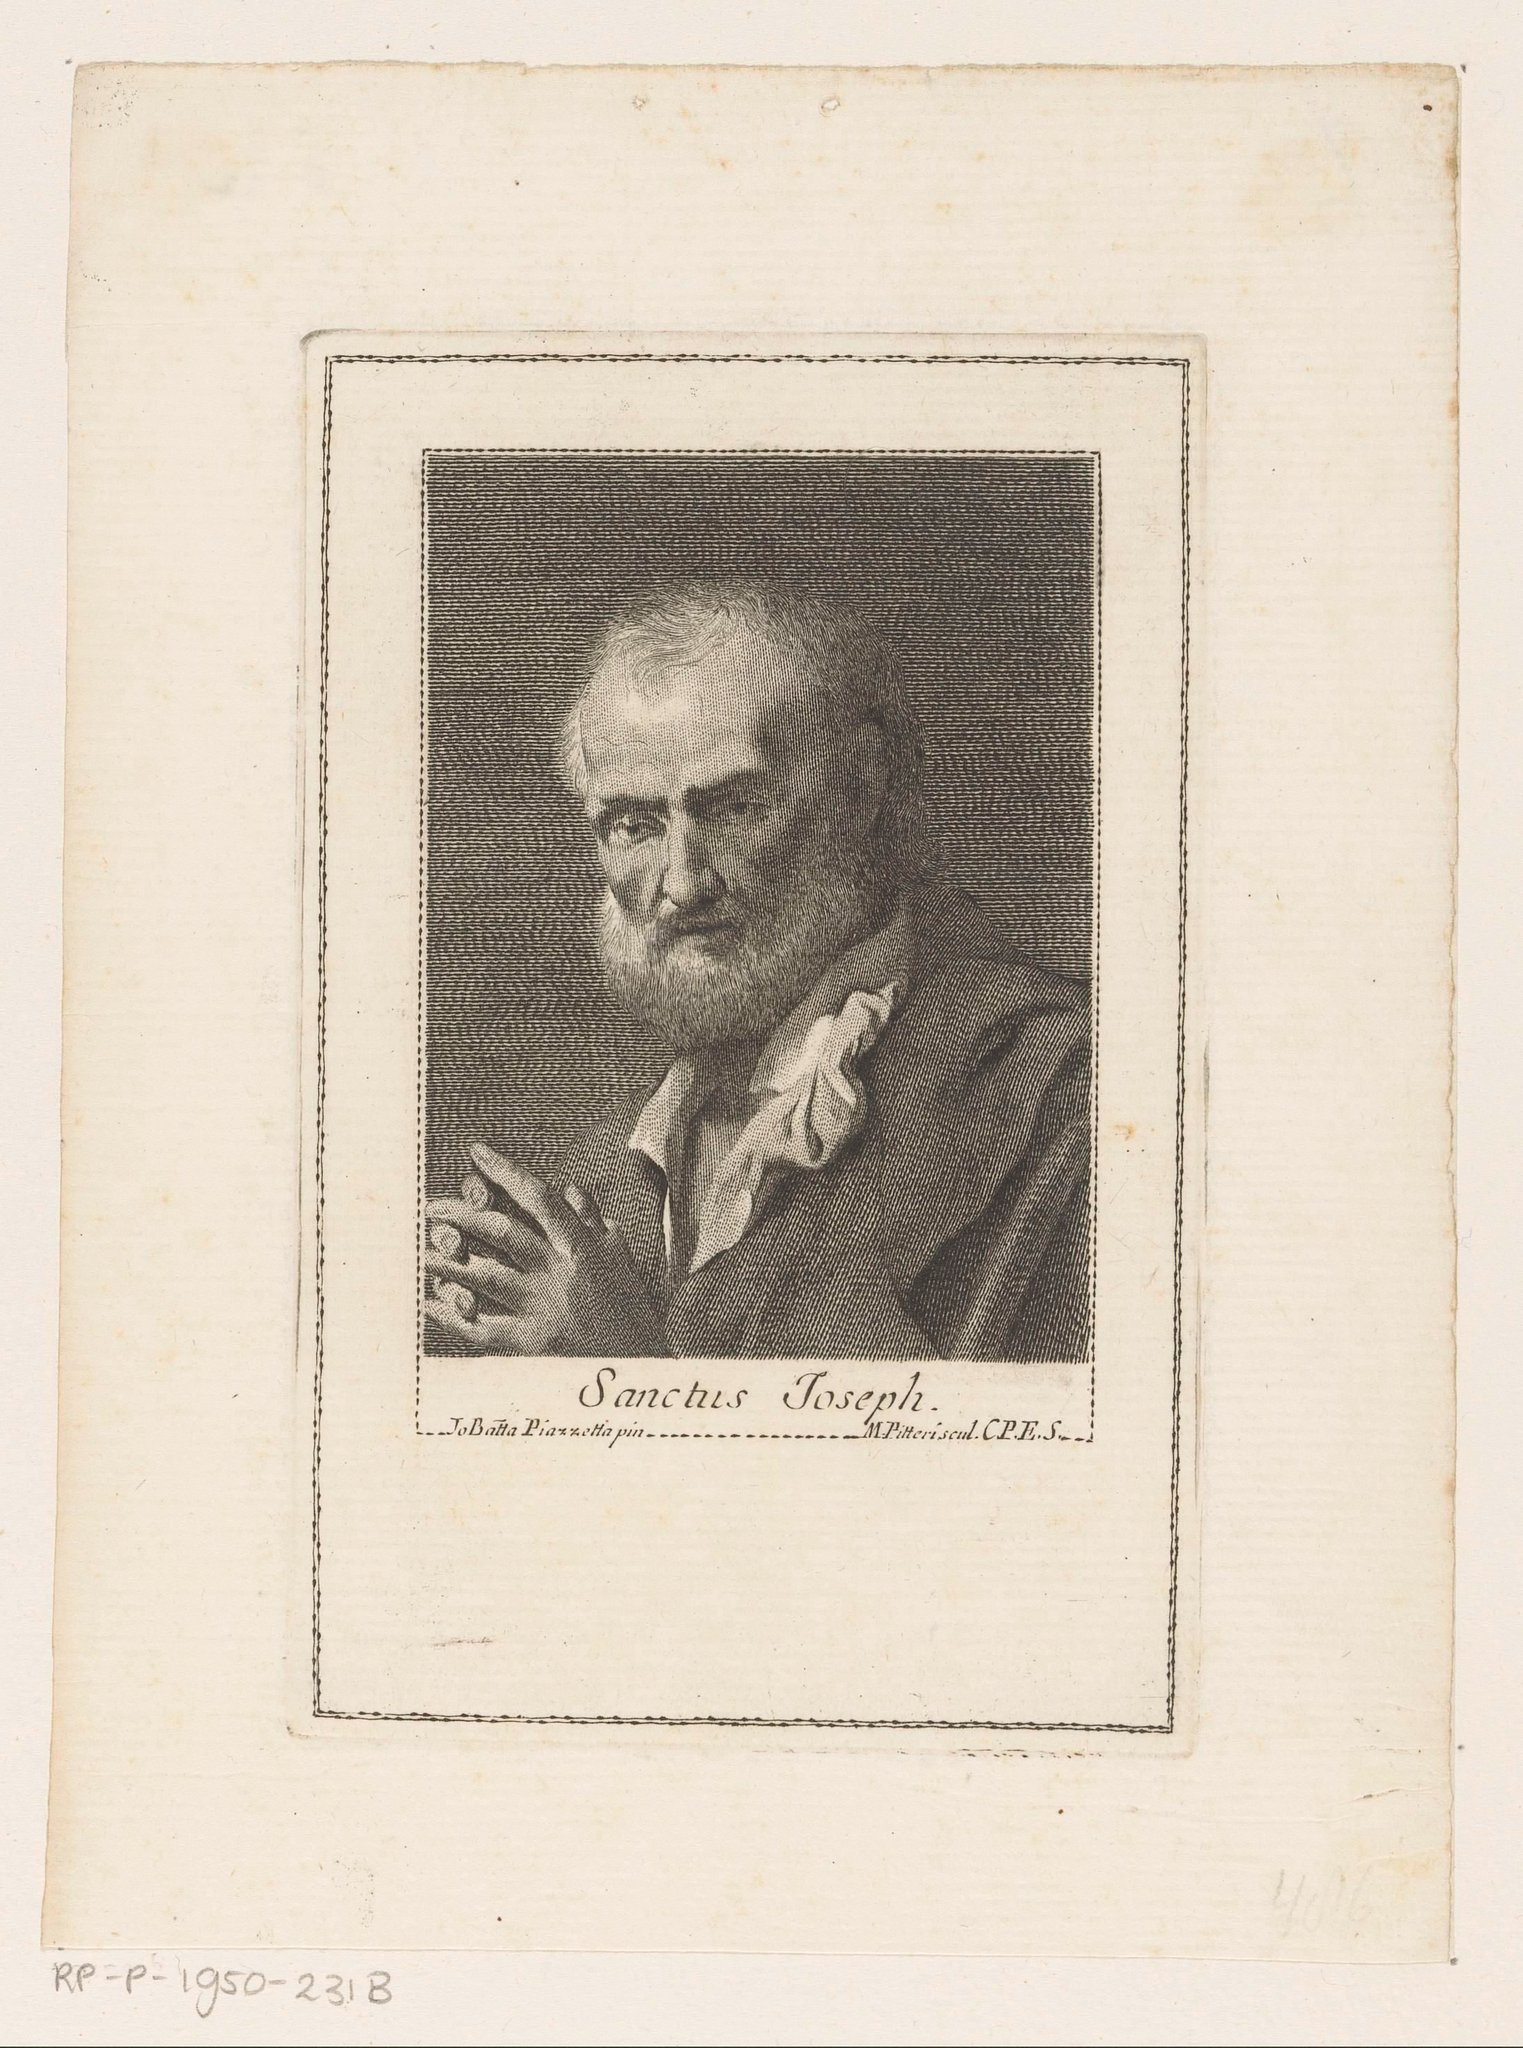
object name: print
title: Sanctus Joseph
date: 1712-1786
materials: paper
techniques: engraving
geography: venice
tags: the foster-father of christ, joseph of nazareth, husband of mary; possible attributes: flowering rod or wand, lily, carpenter's tools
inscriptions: collector's mark: Lugt 2228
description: In de literatuur worden alleen de twaalf apostelen samen als serie geteld. Maar uit de collectie van het Rijksmuseum kunnen we opmaken dat de serie uit ten minste 19 prenten en een titelprent bestond.